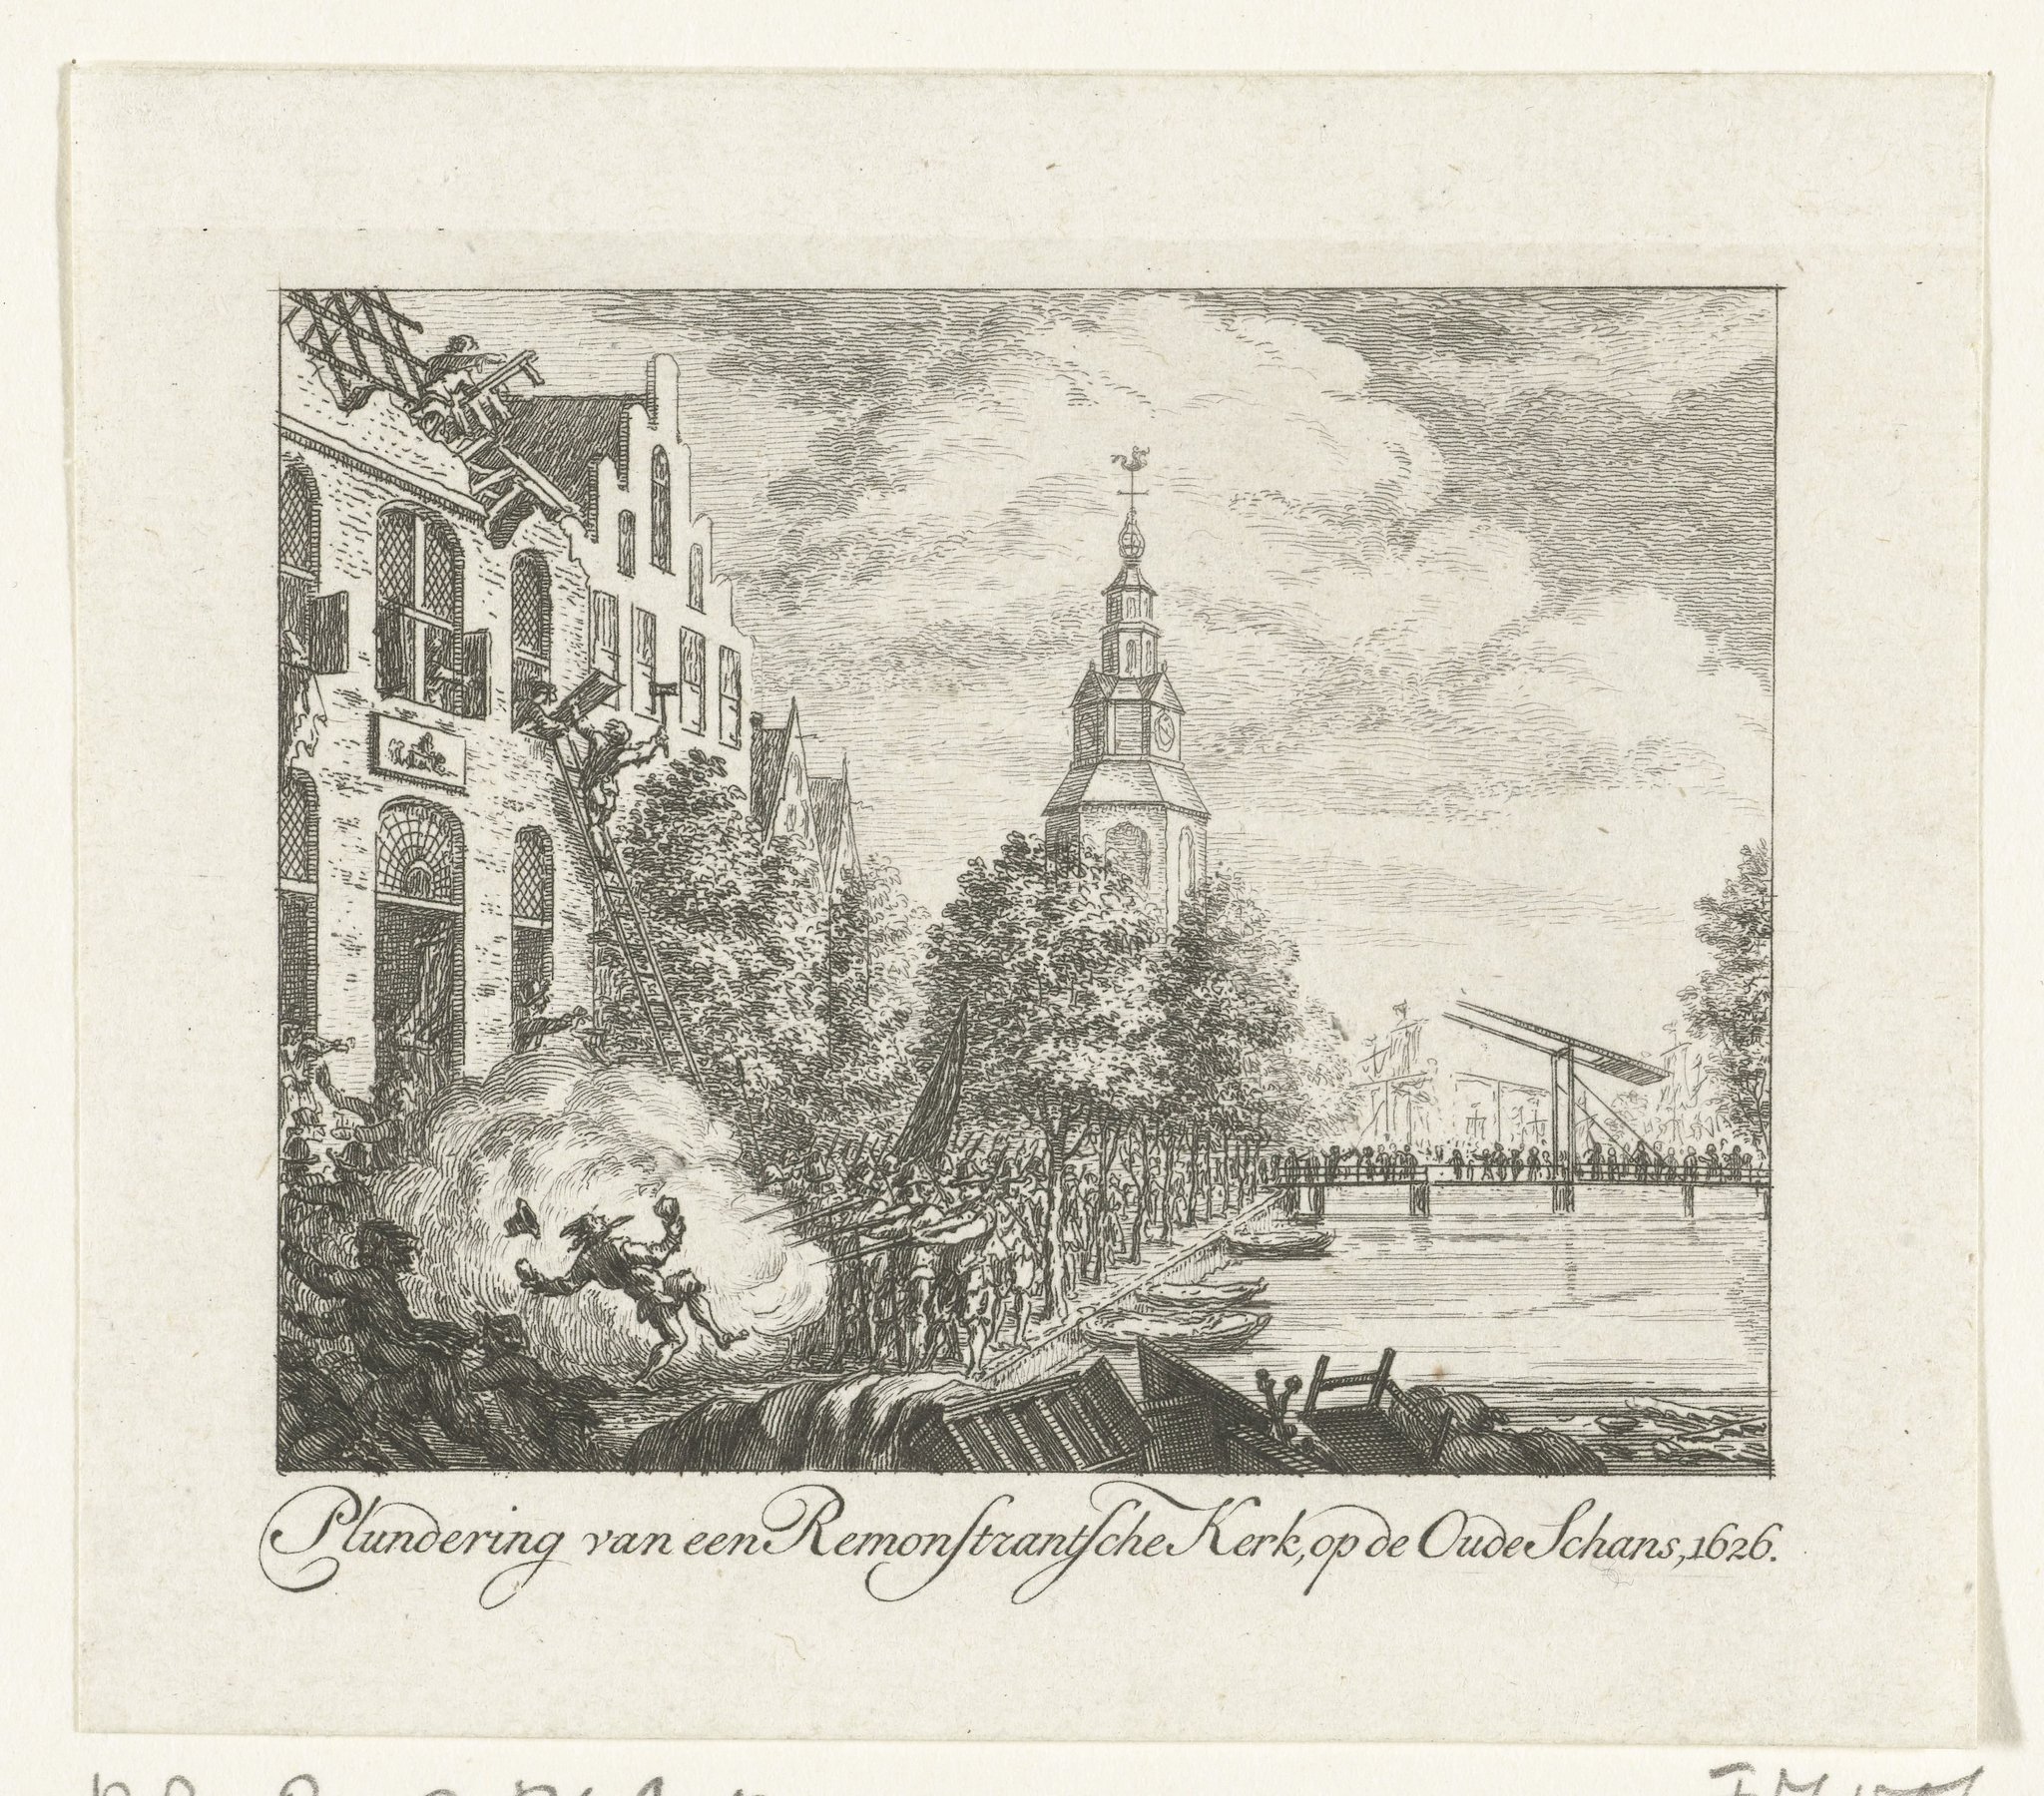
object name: print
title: Plundering van een Remonstrantse kerk op de Oude Schans, 1626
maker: simon fokke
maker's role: draughtsman, print maker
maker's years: 1712-1784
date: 1779-1781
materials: paper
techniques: etching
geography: northern netherlands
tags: plundering ~ riot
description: Volgens de catalogus van de Atlas van Stolk onderdeel van een serie van 7 prentjes van straatoproer te Amsterdam, in 1781 verschenen.